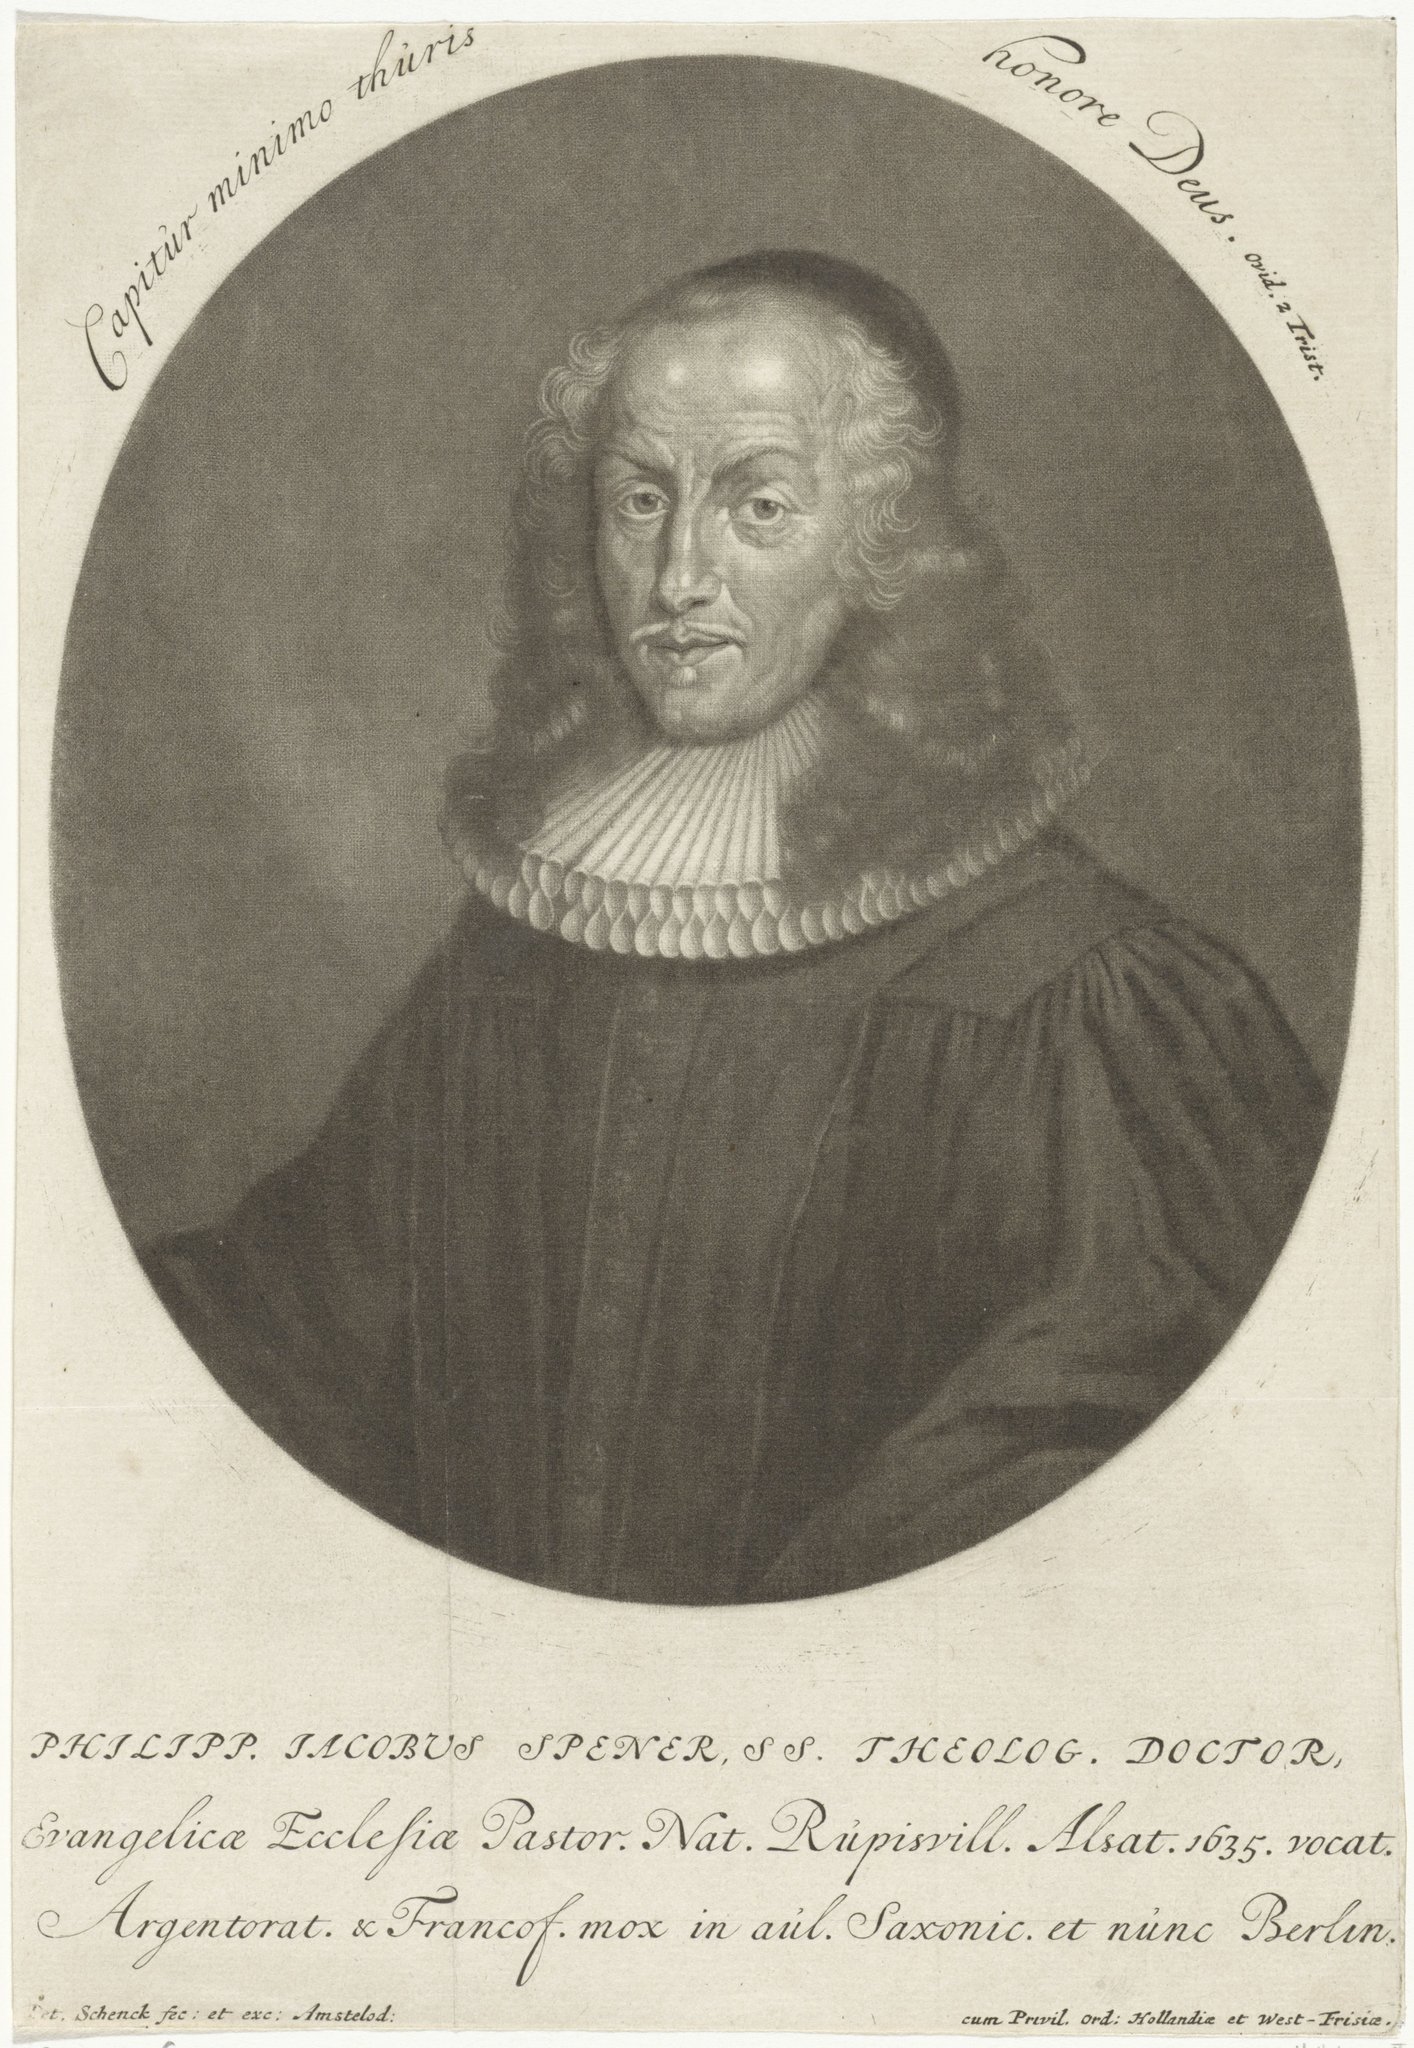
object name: print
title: Portret van de theoloog Philipp Jacob Spener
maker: pieter schenk (i)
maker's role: print maker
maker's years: 1660-1711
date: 1670-1713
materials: paper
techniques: engraving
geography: amsterdam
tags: berlin, philipp jacob spener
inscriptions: collector's mark: Lugt 2228